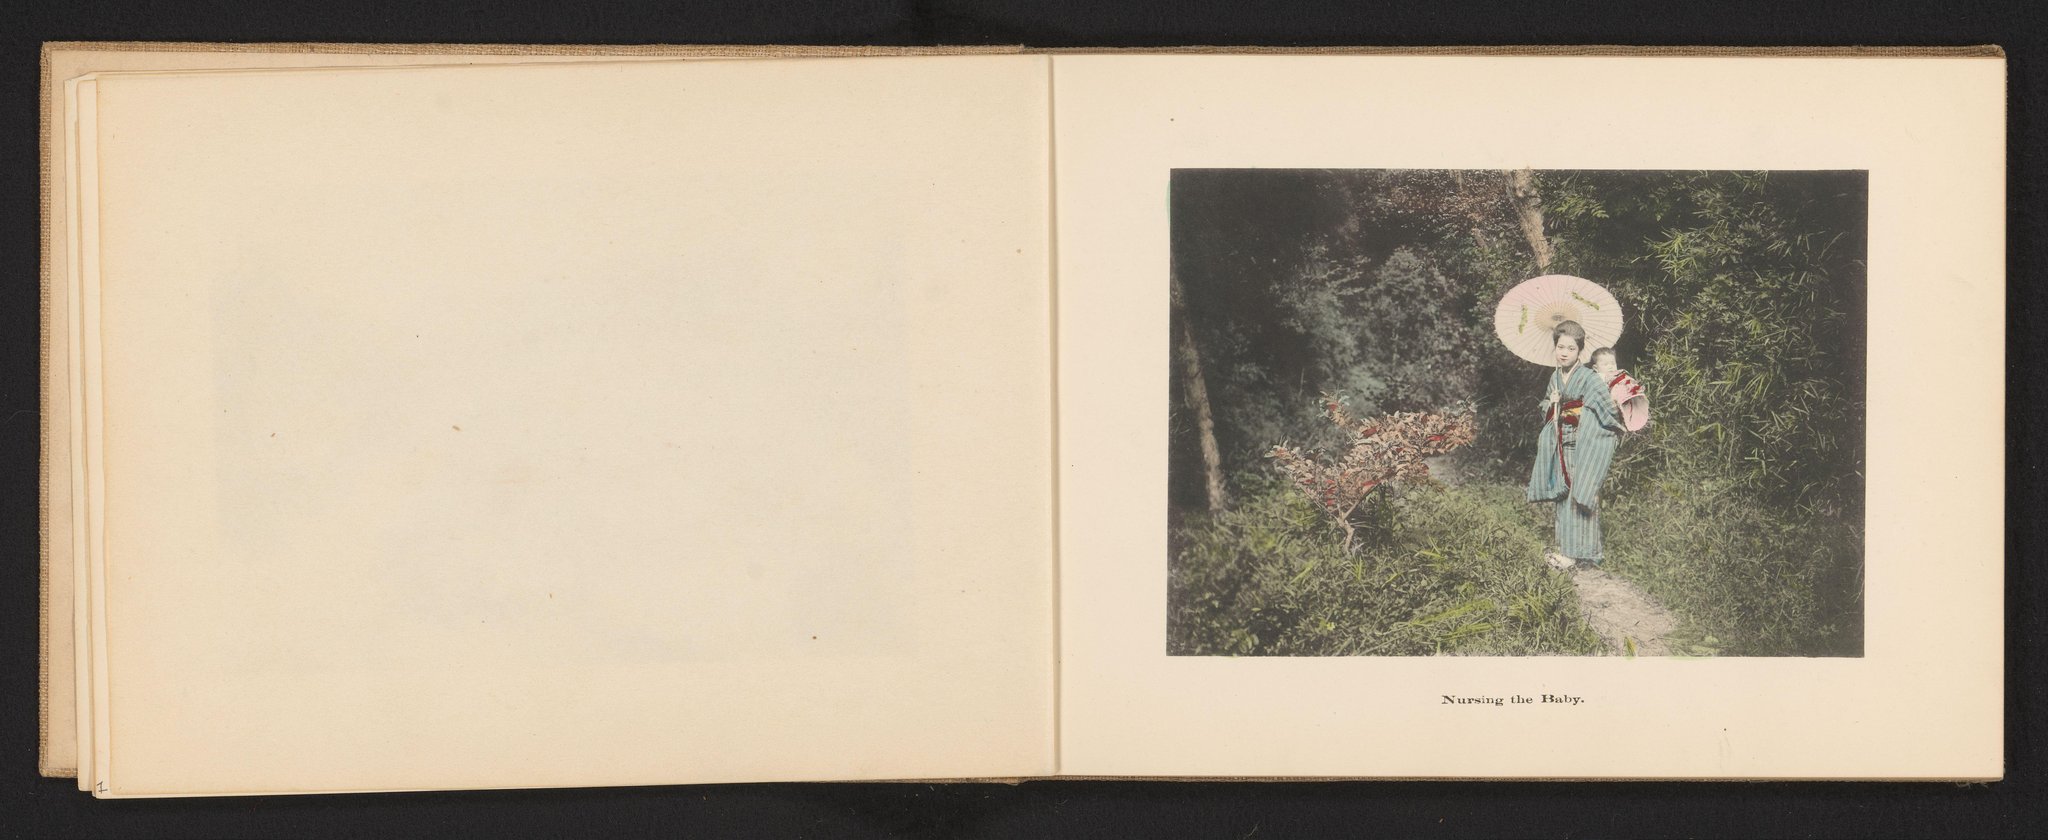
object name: photomechanical print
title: Vrouw in traditionele Japanse kleding met een parasol die een baby op haar rug draagt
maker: kōzaburō tamamura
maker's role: fotograaf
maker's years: 1856-1923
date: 1895-1905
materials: paper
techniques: photograph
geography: japan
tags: folk costume, regional costume, carrying a child on the back, japan